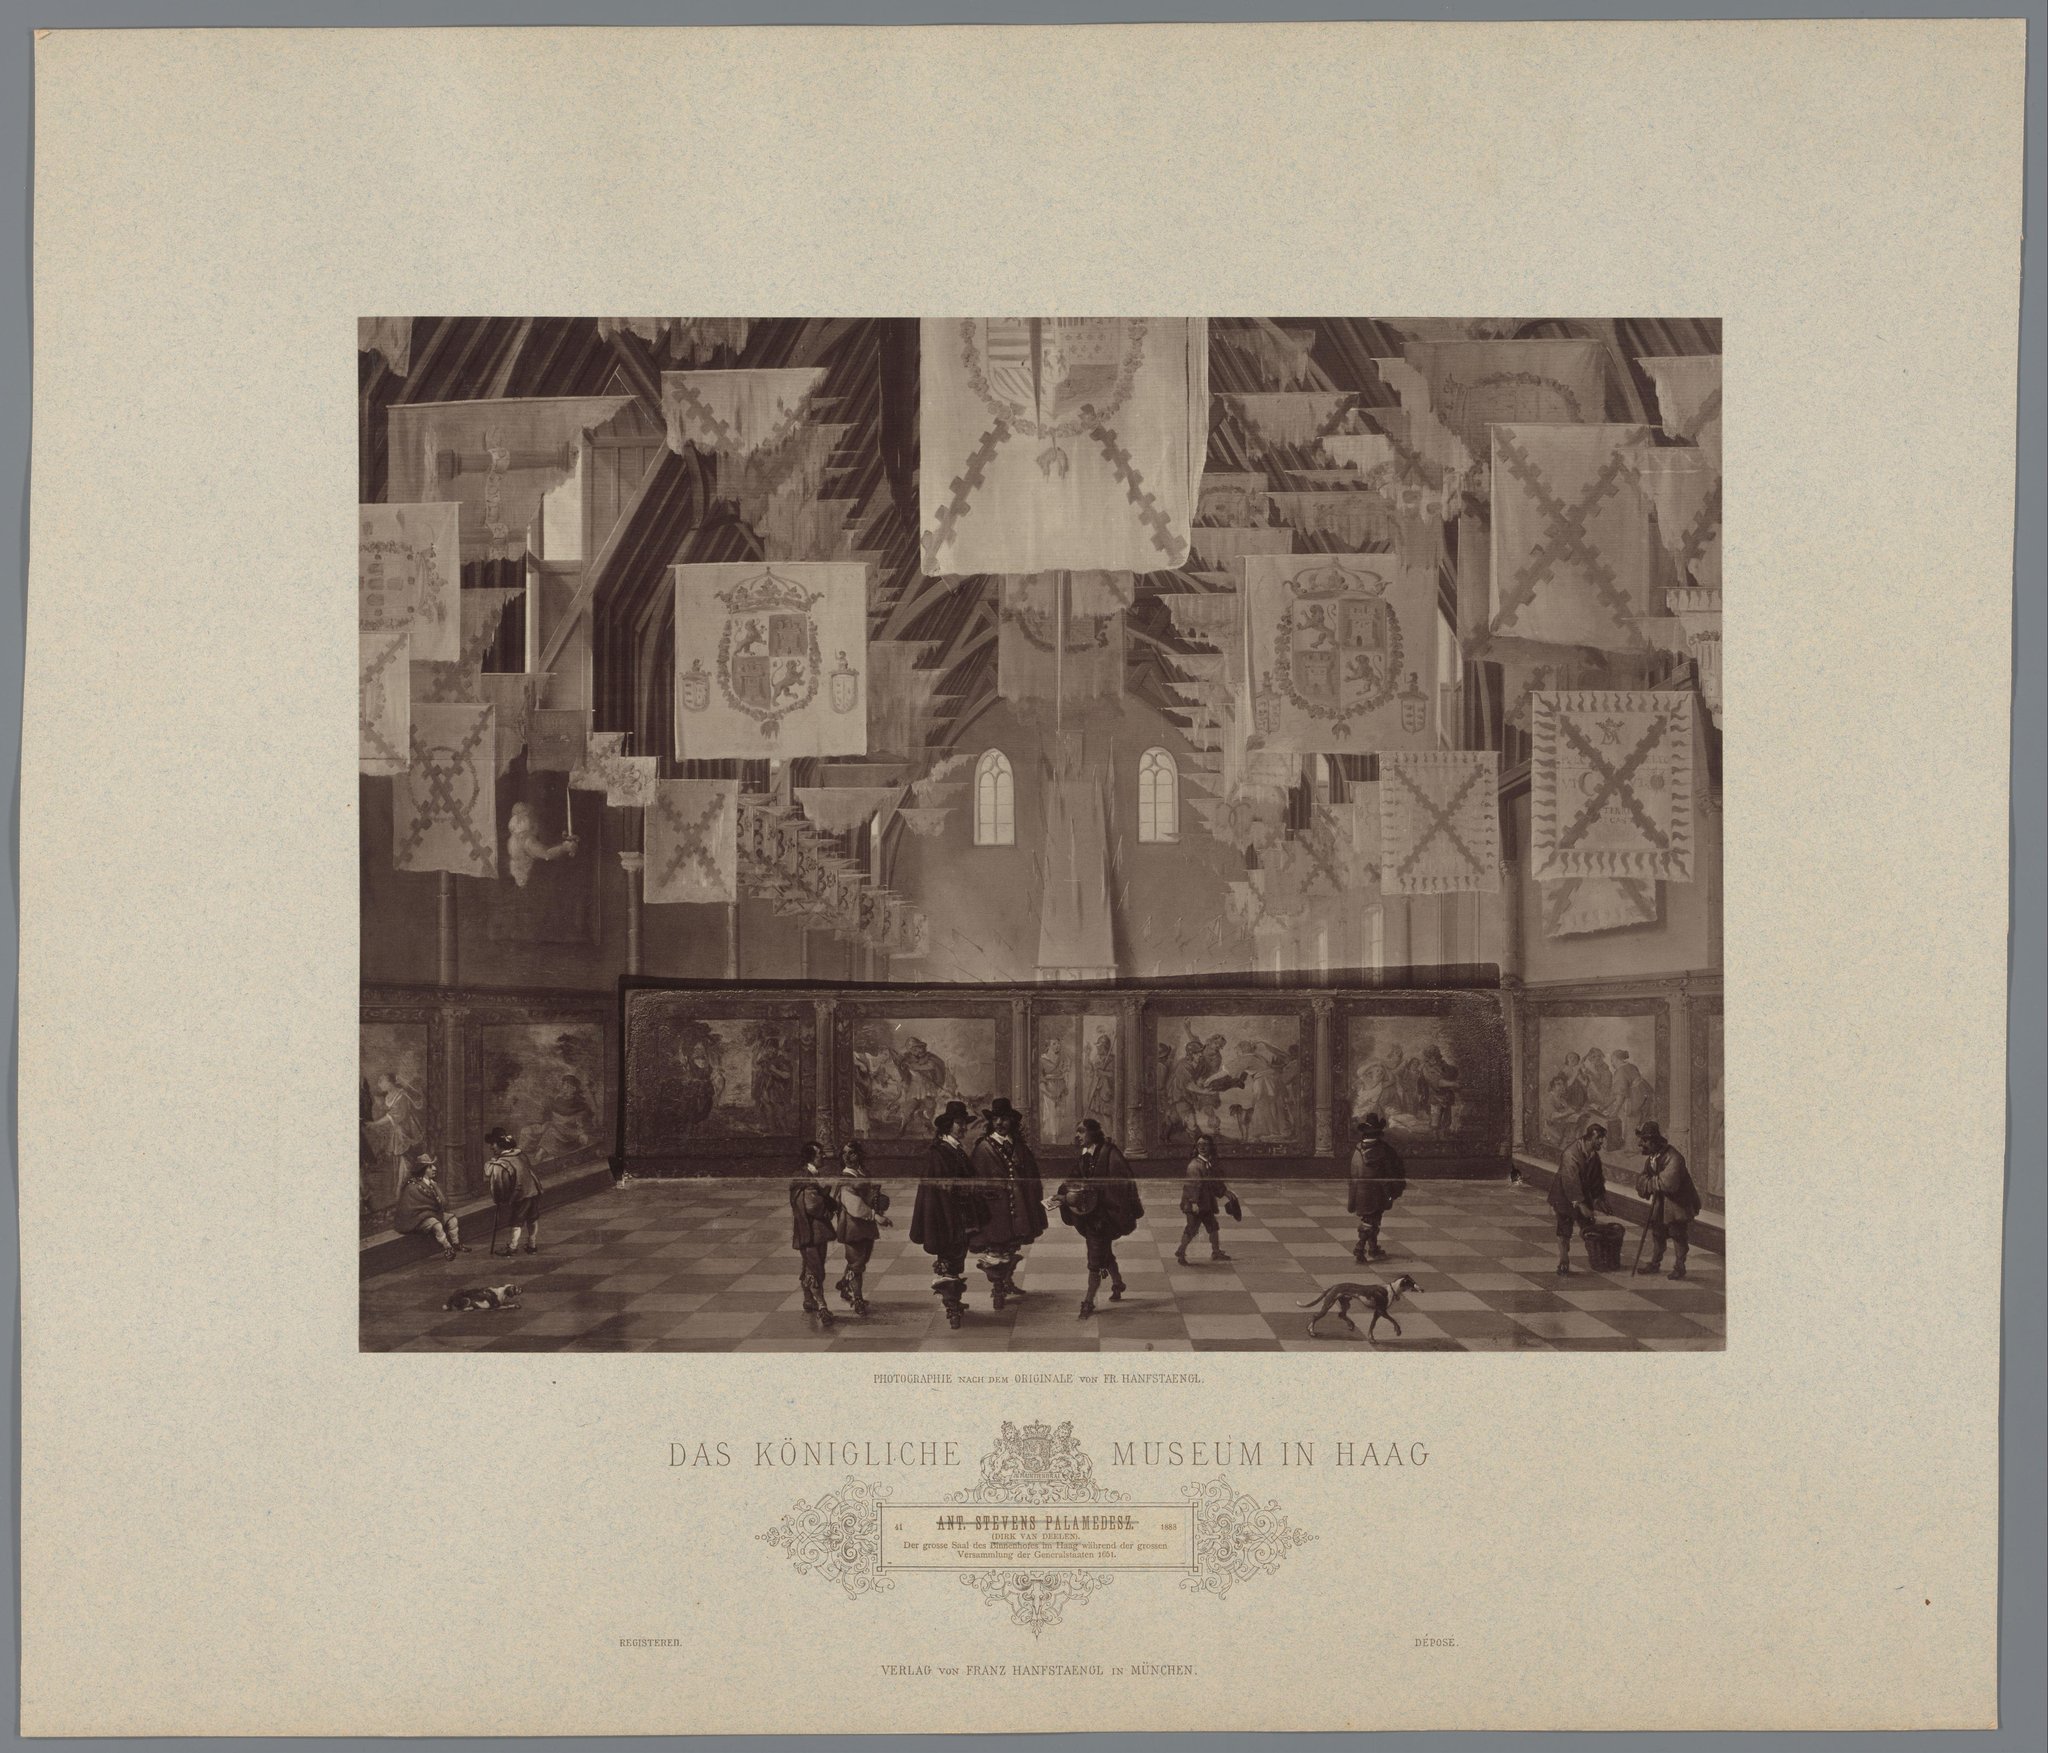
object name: photograph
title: Fotoreproductie van schilderij De grote zaal van het Binnenhof tijdens de bijeenkomst van de Staten-Generaal in 1651 door Dirck van Delen, coll. Mauritshuis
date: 1888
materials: cardboard, paper, photographic support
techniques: collodion silver print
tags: picture, painting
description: Das Königliche Museum in Haag / Ant. Stevens Palamedesz. / (Dirkvan Deelen). / Der grosse Saal des Binnenhofes in Haag während der grossen Versammlung der Generalstaaten 1651.